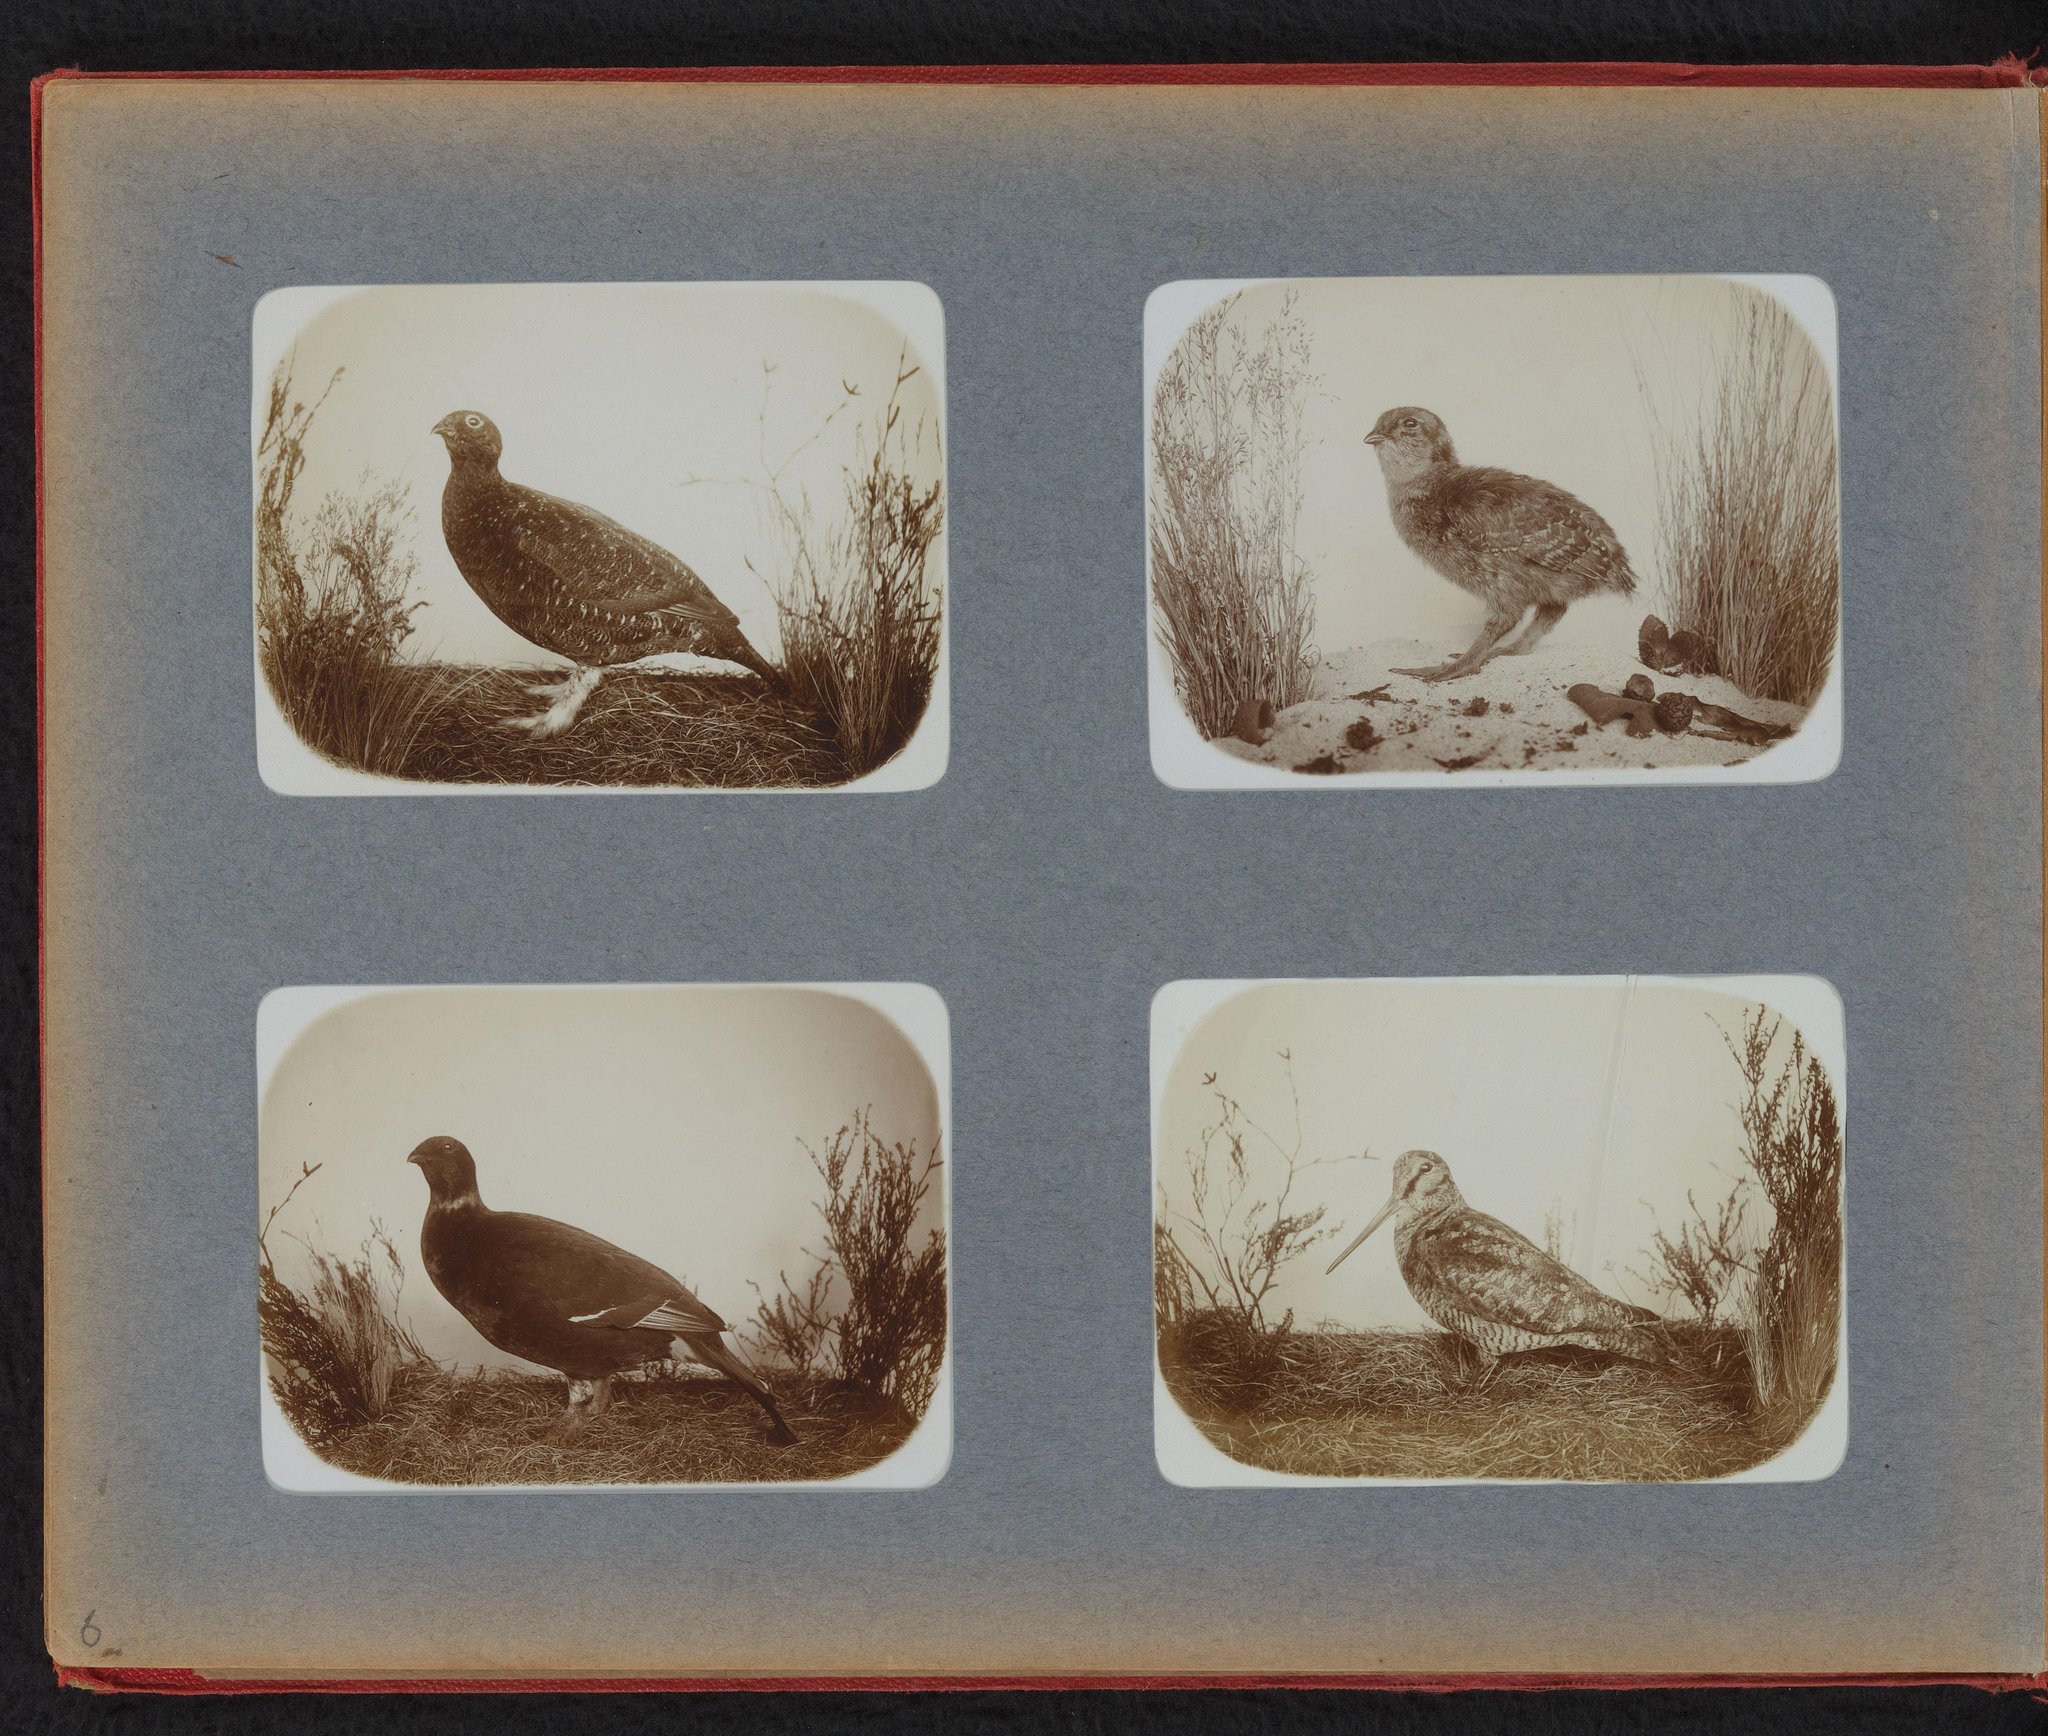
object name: photograph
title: Vier opgezette fazantachtigen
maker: Anonymous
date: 1895-1910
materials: paper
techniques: gelatin silver print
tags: walker and runner birds: pheasant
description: Deze foto's maken deel uit van een album.